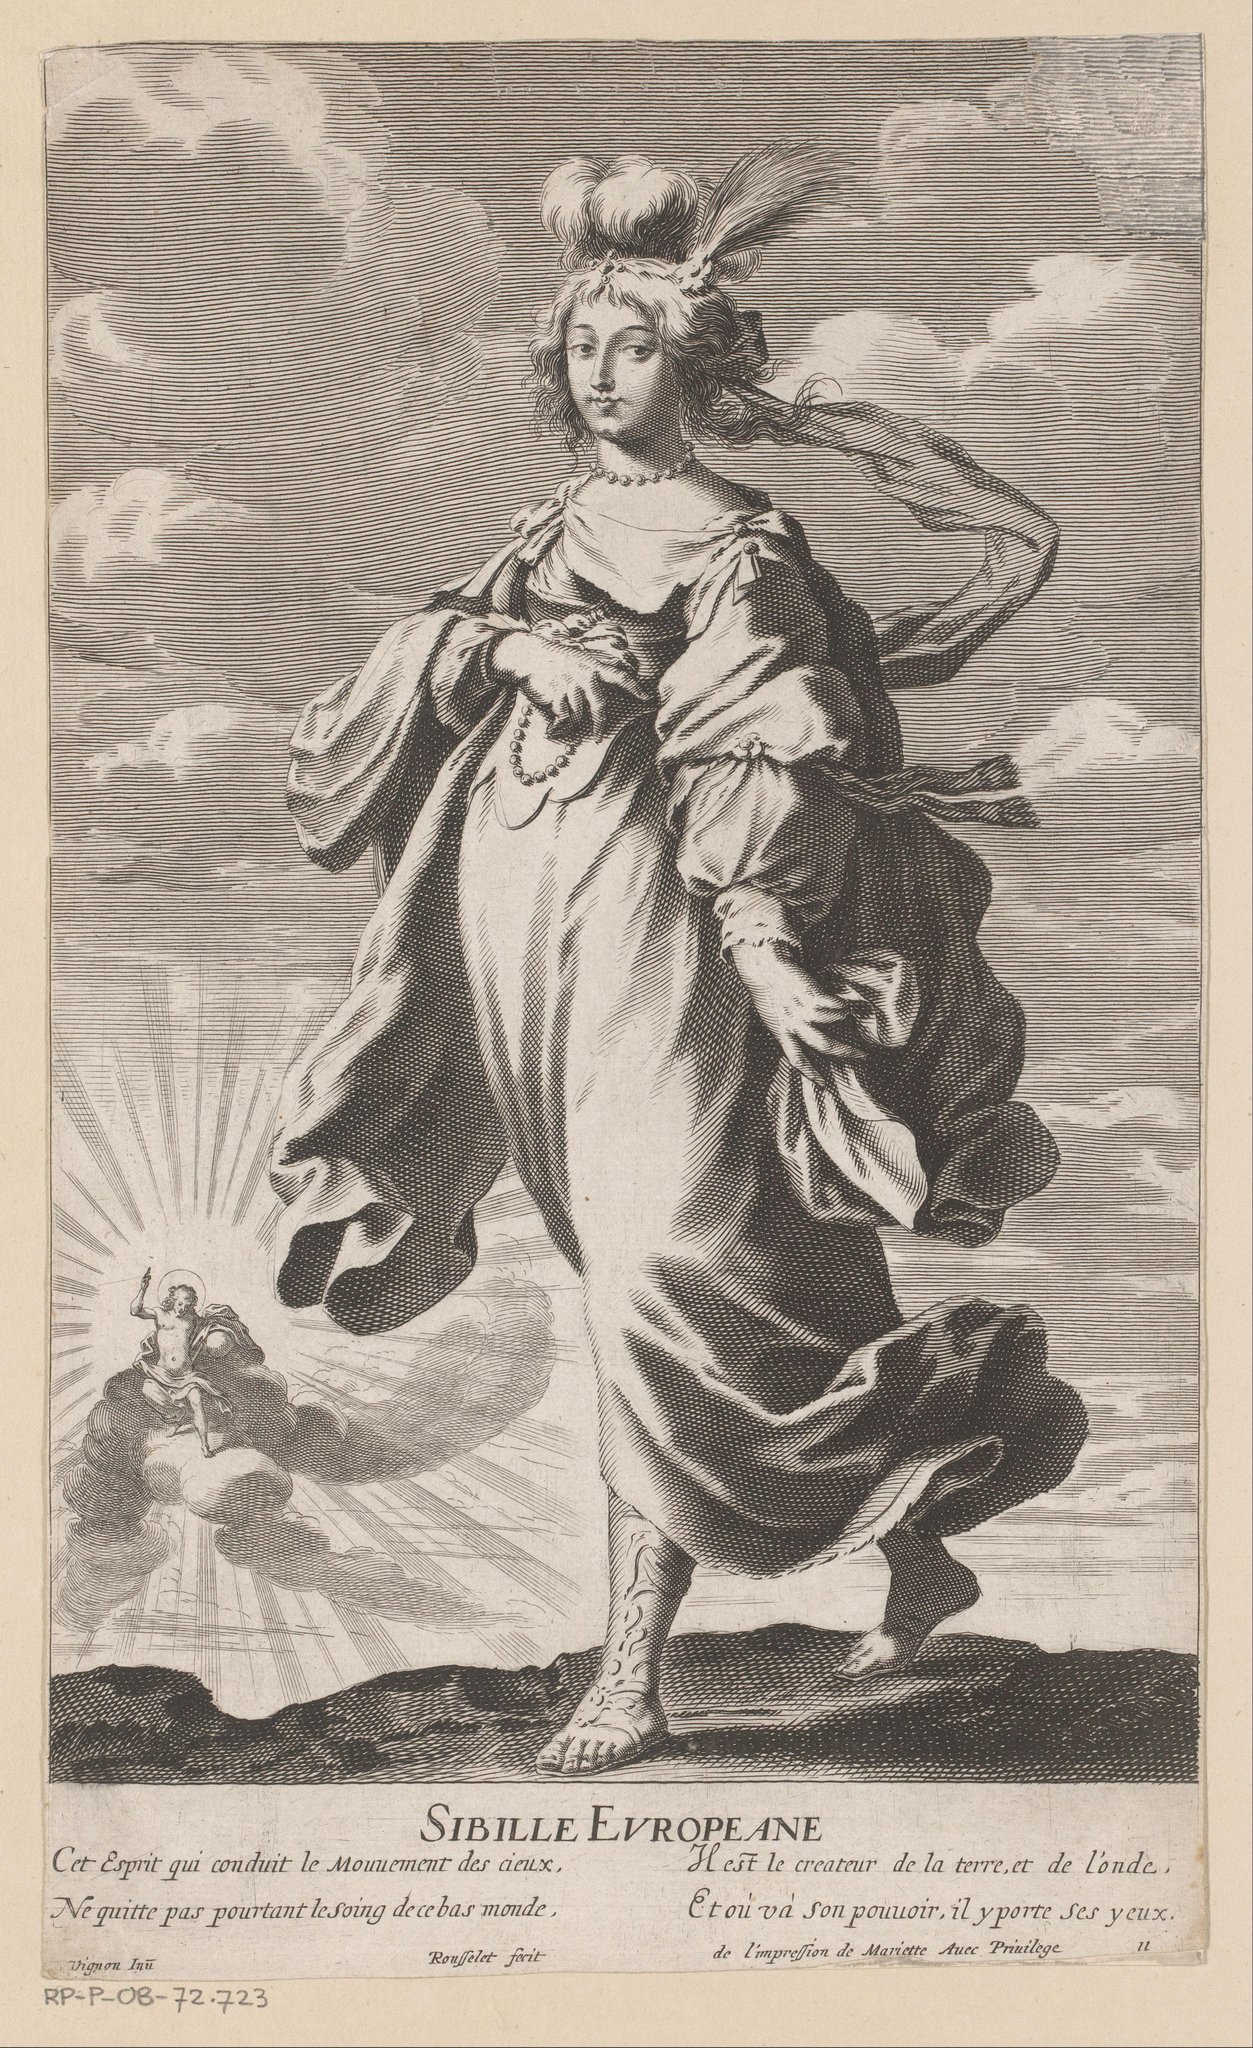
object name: print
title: Les Sibylles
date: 1635-1640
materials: paper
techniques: engraving, etching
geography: france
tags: sibyls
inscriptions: collector's mark: Lugt 240